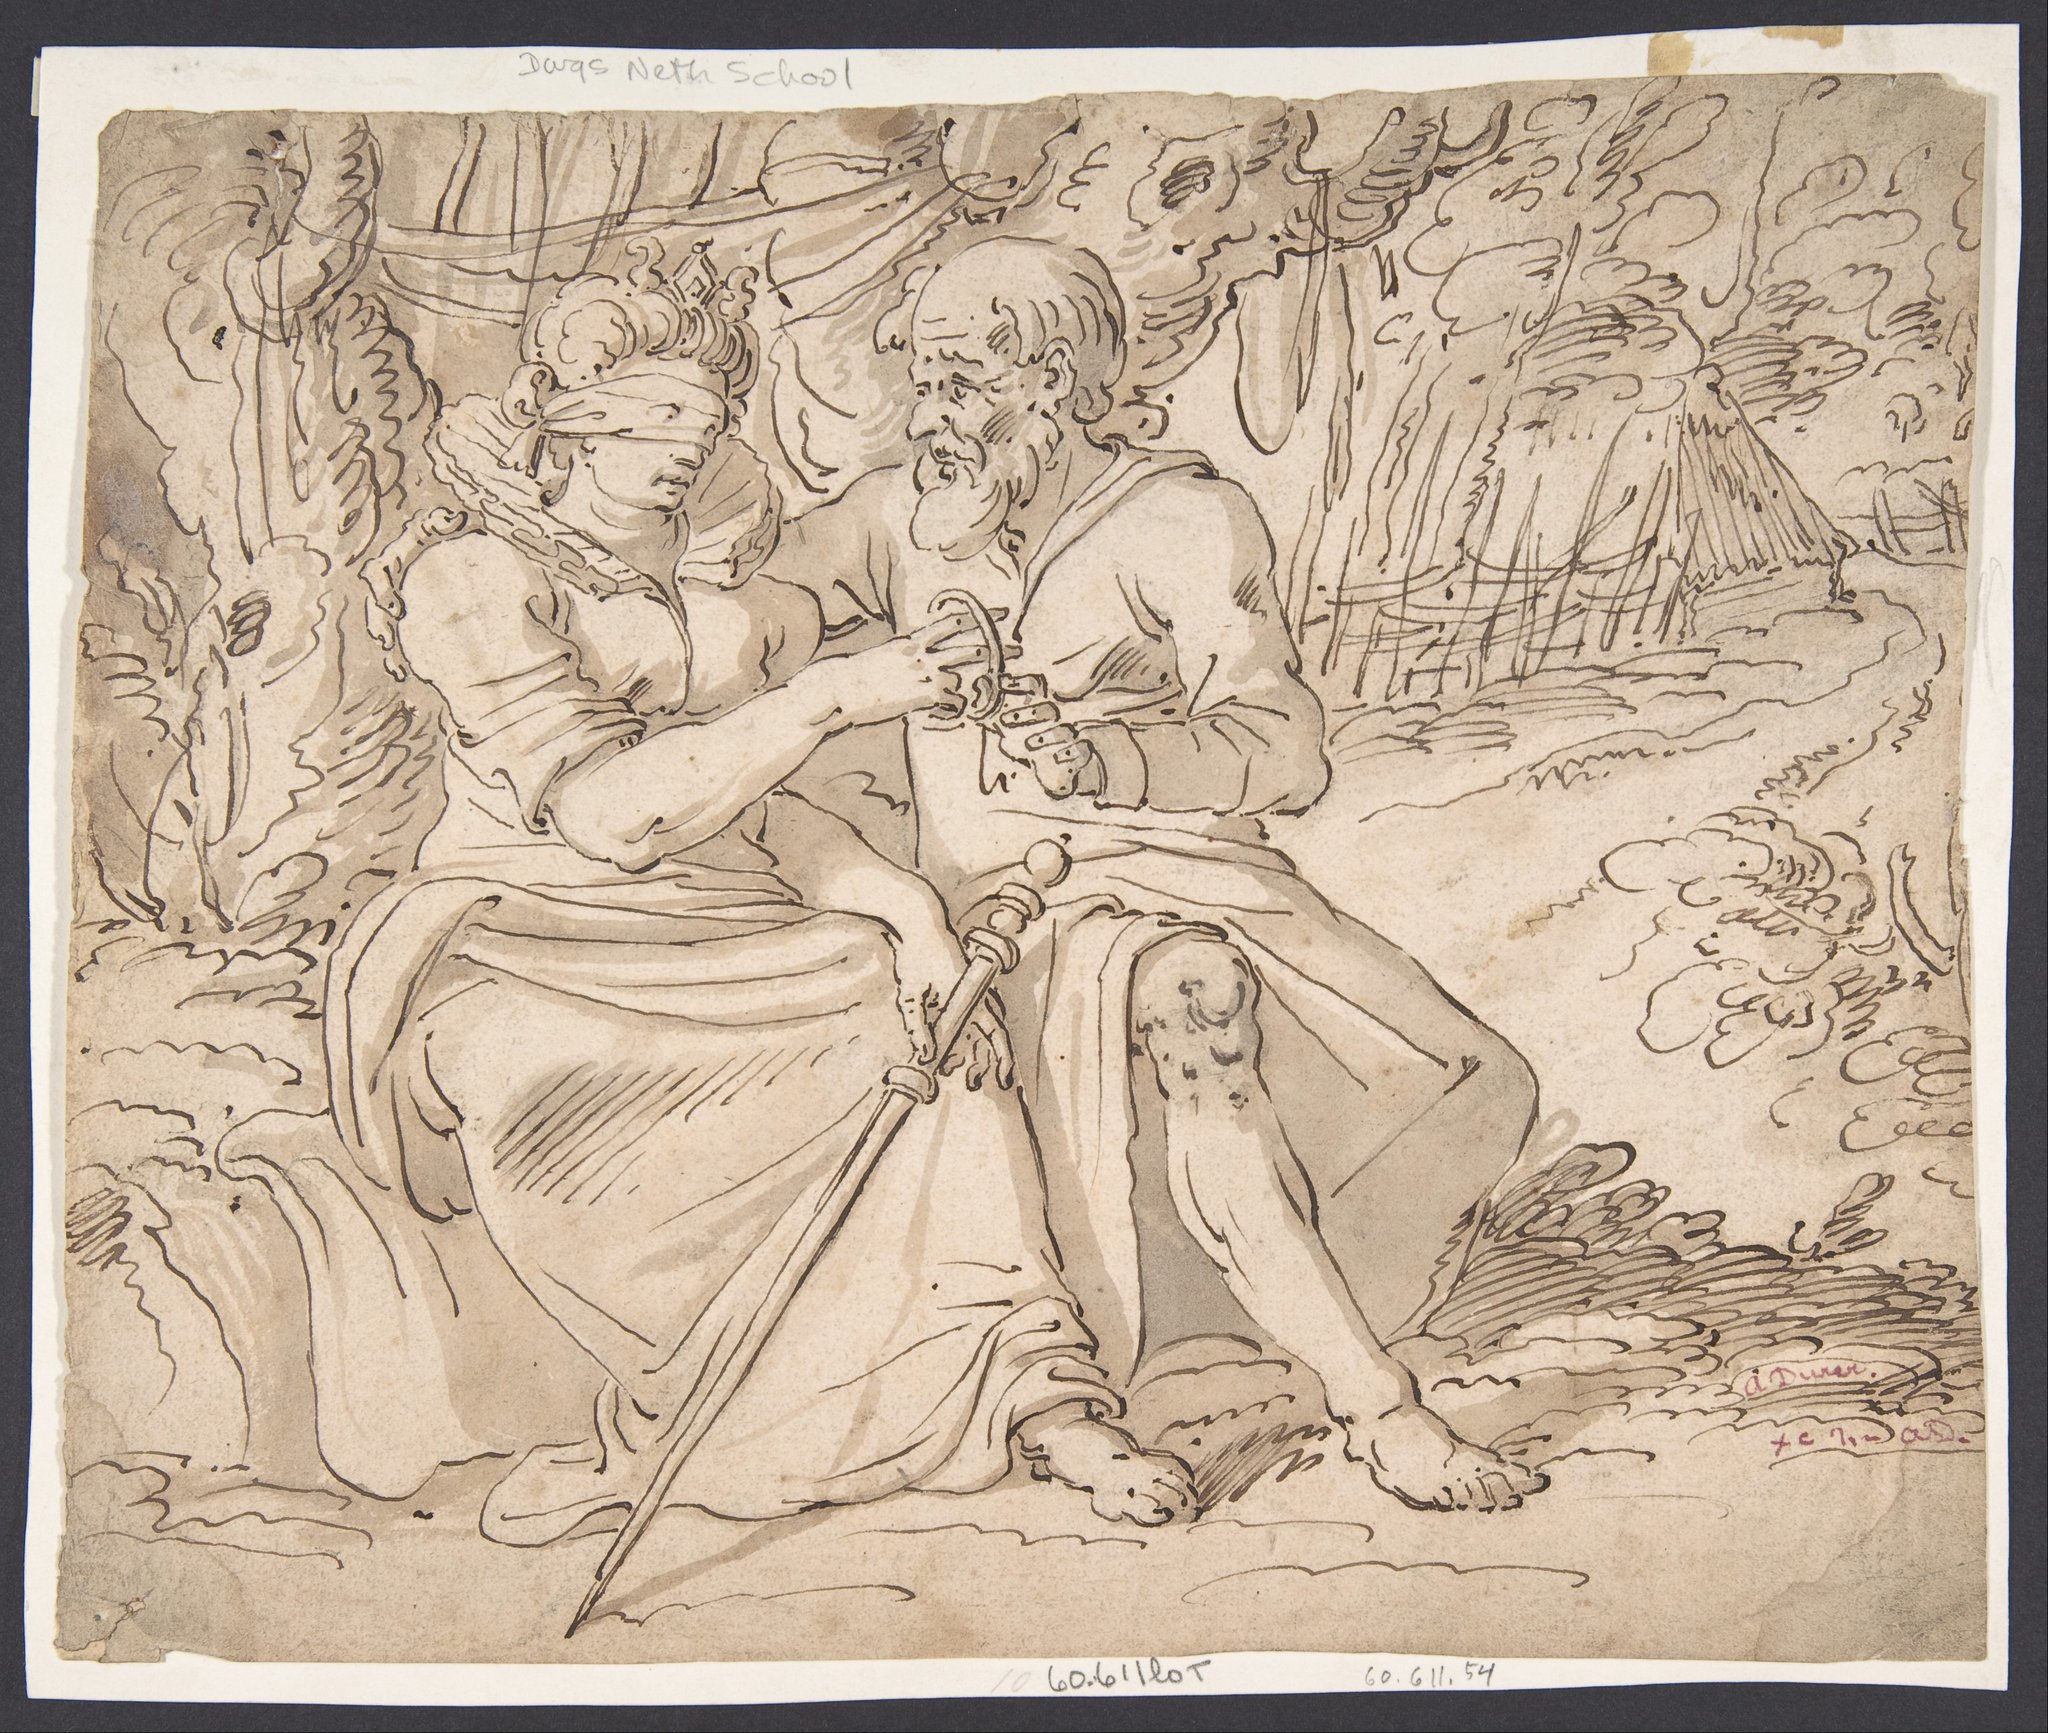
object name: drawing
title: Judah Giving Tamar his Staff and Bracelets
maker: anonymous, netherlandish, 16th century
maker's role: artist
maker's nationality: netherlandish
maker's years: 1500-1600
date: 1501-1600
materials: chalk, down, ink, paper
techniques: brush, pen, wash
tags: bracelets,men,women